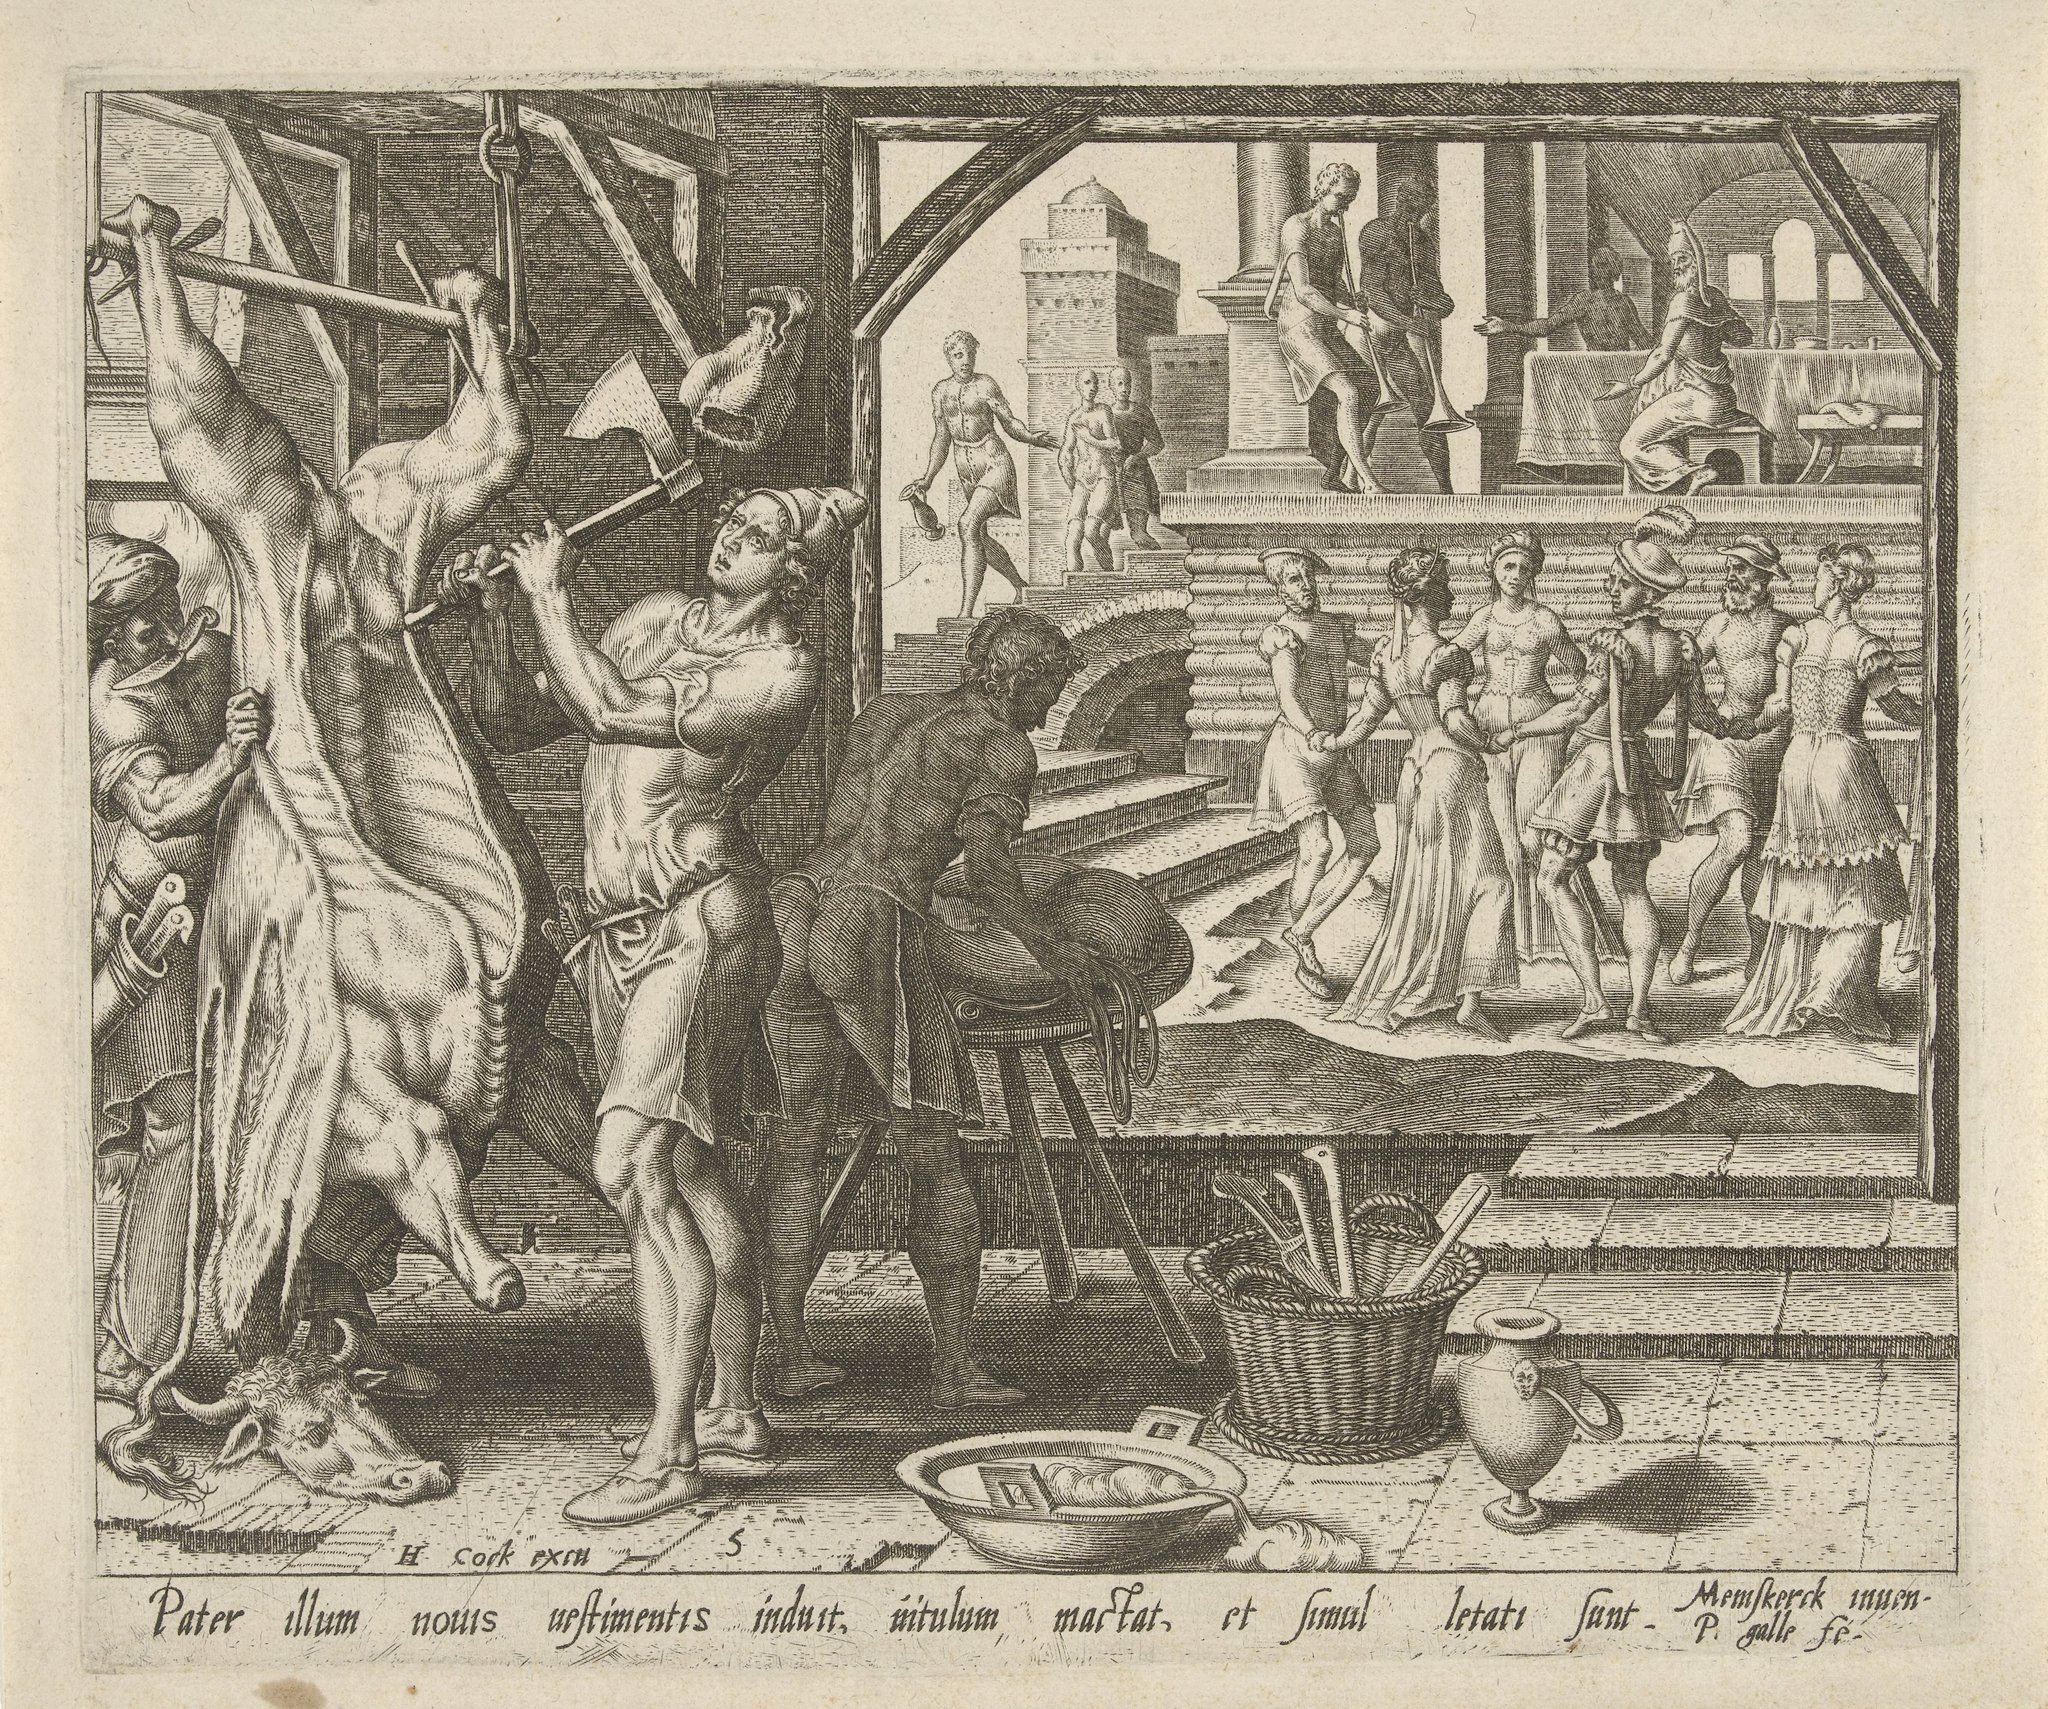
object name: print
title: Het vetgemeste kalf wordt geslacht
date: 1562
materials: paper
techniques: engraving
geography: haarlem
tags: preparations, e.g. the prodigal son is given new robes; slaughtering of the fatted calf; the elder son objects, the parable of the prodigal son (luke 15:11-32)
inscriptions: collector's mark: Lugt 2228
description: Ter ere van de thuiskomst van de verloren zoon wordt een vetgemest kalf geslacht. Op de binnenplaats danst de verloren zoon met de gasten. Een lange tafel staat klaar voor het feestmaal.